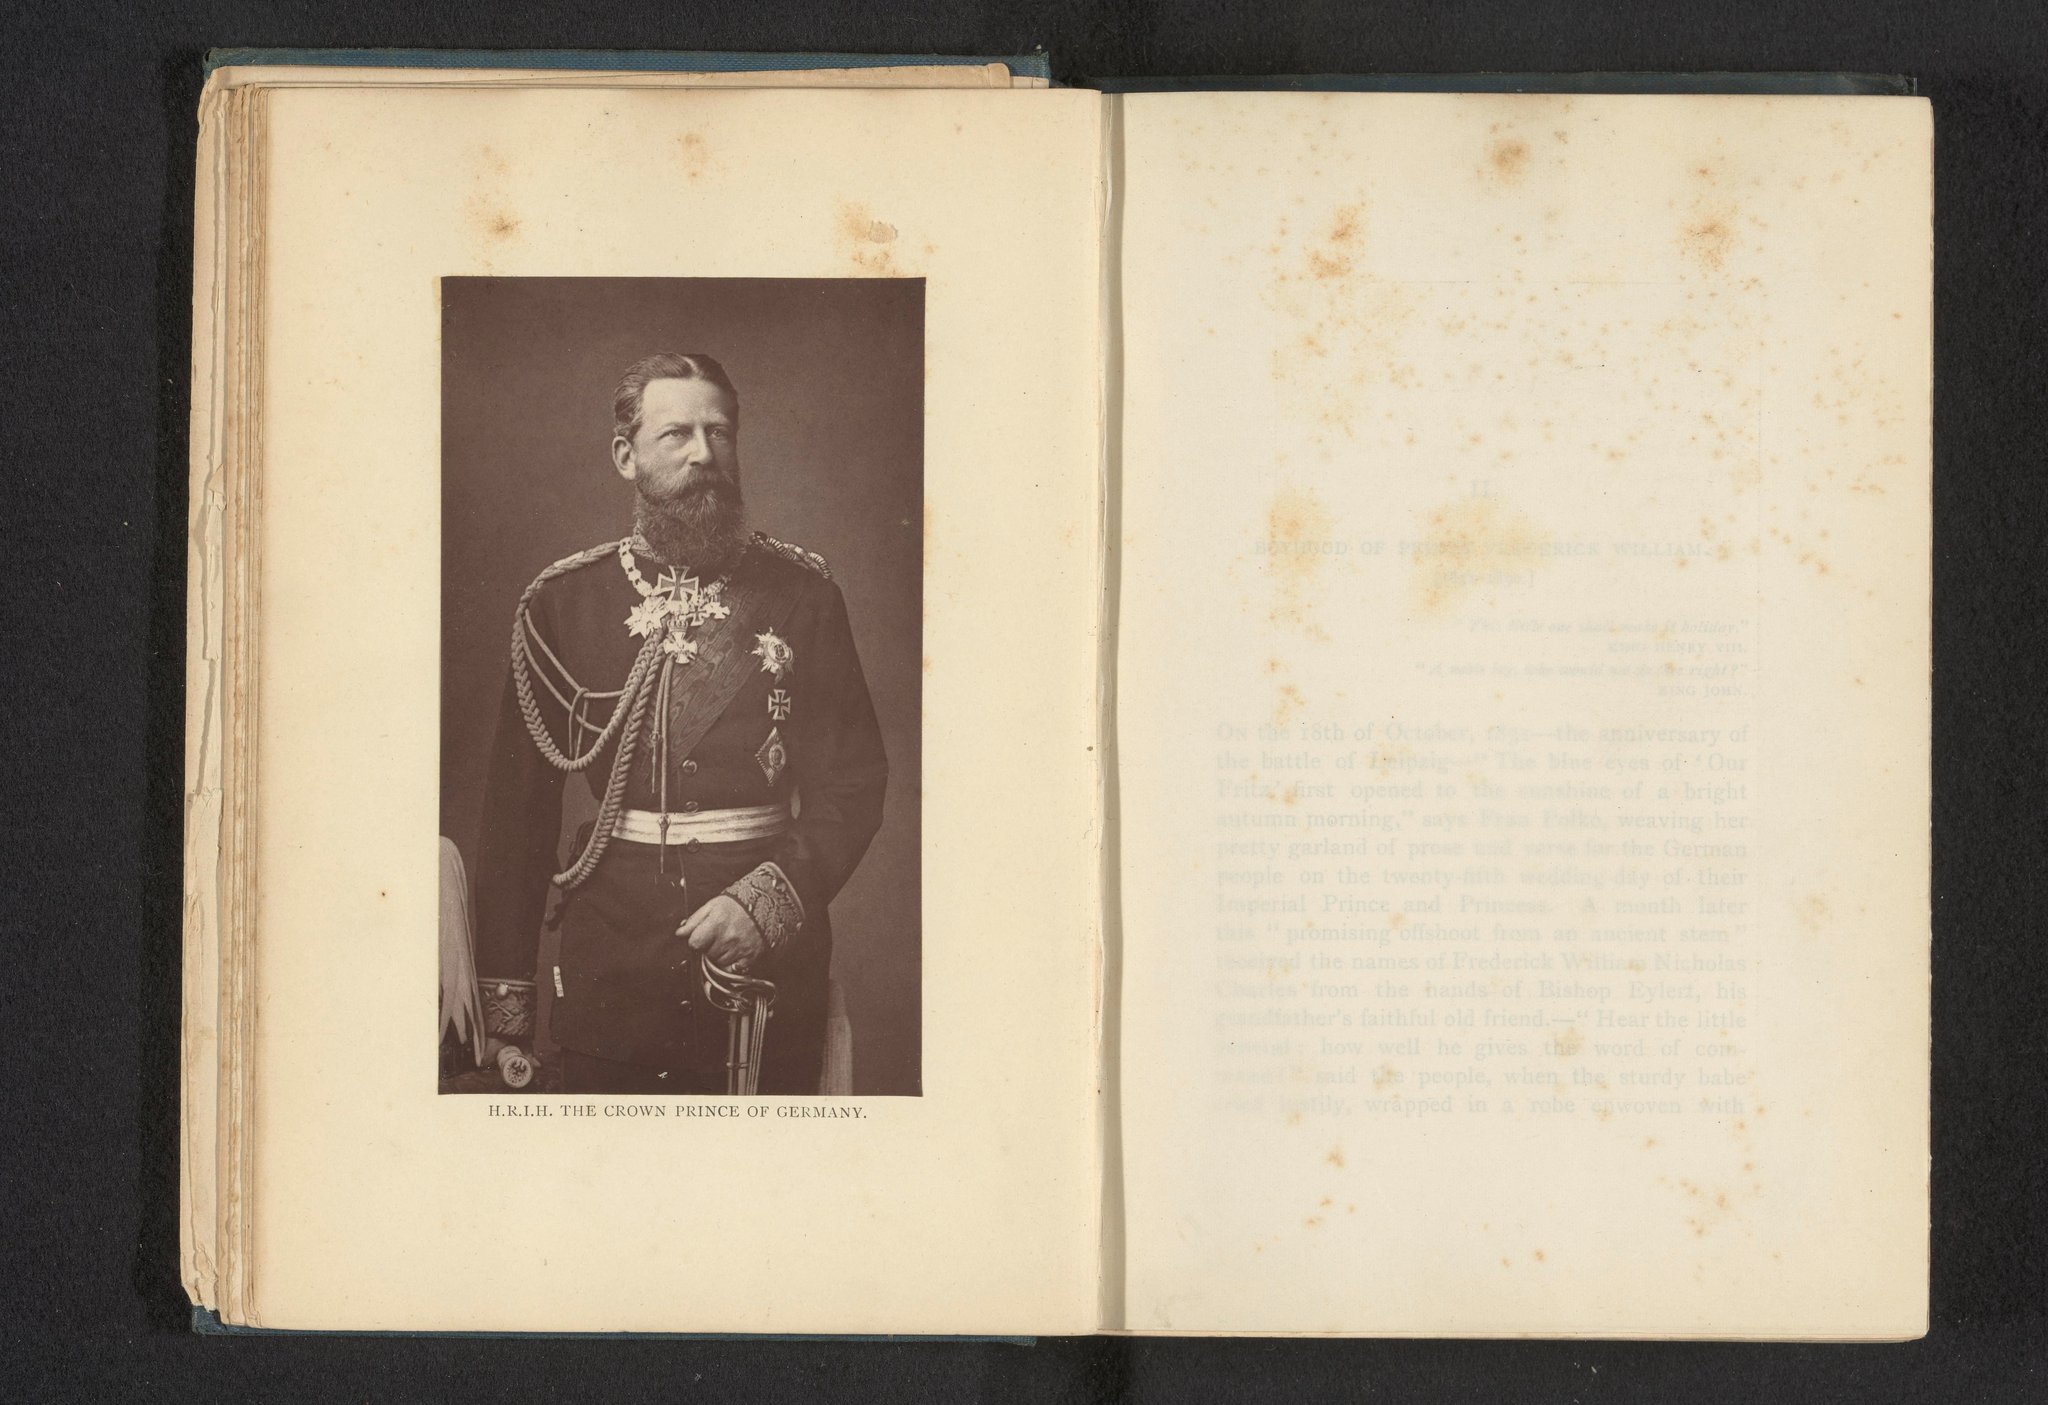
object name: photomechanical print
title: H.R.I.H. the crown prince of Germany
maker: Anonymous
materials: paper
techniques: woodburytype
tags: ruler, sovereign